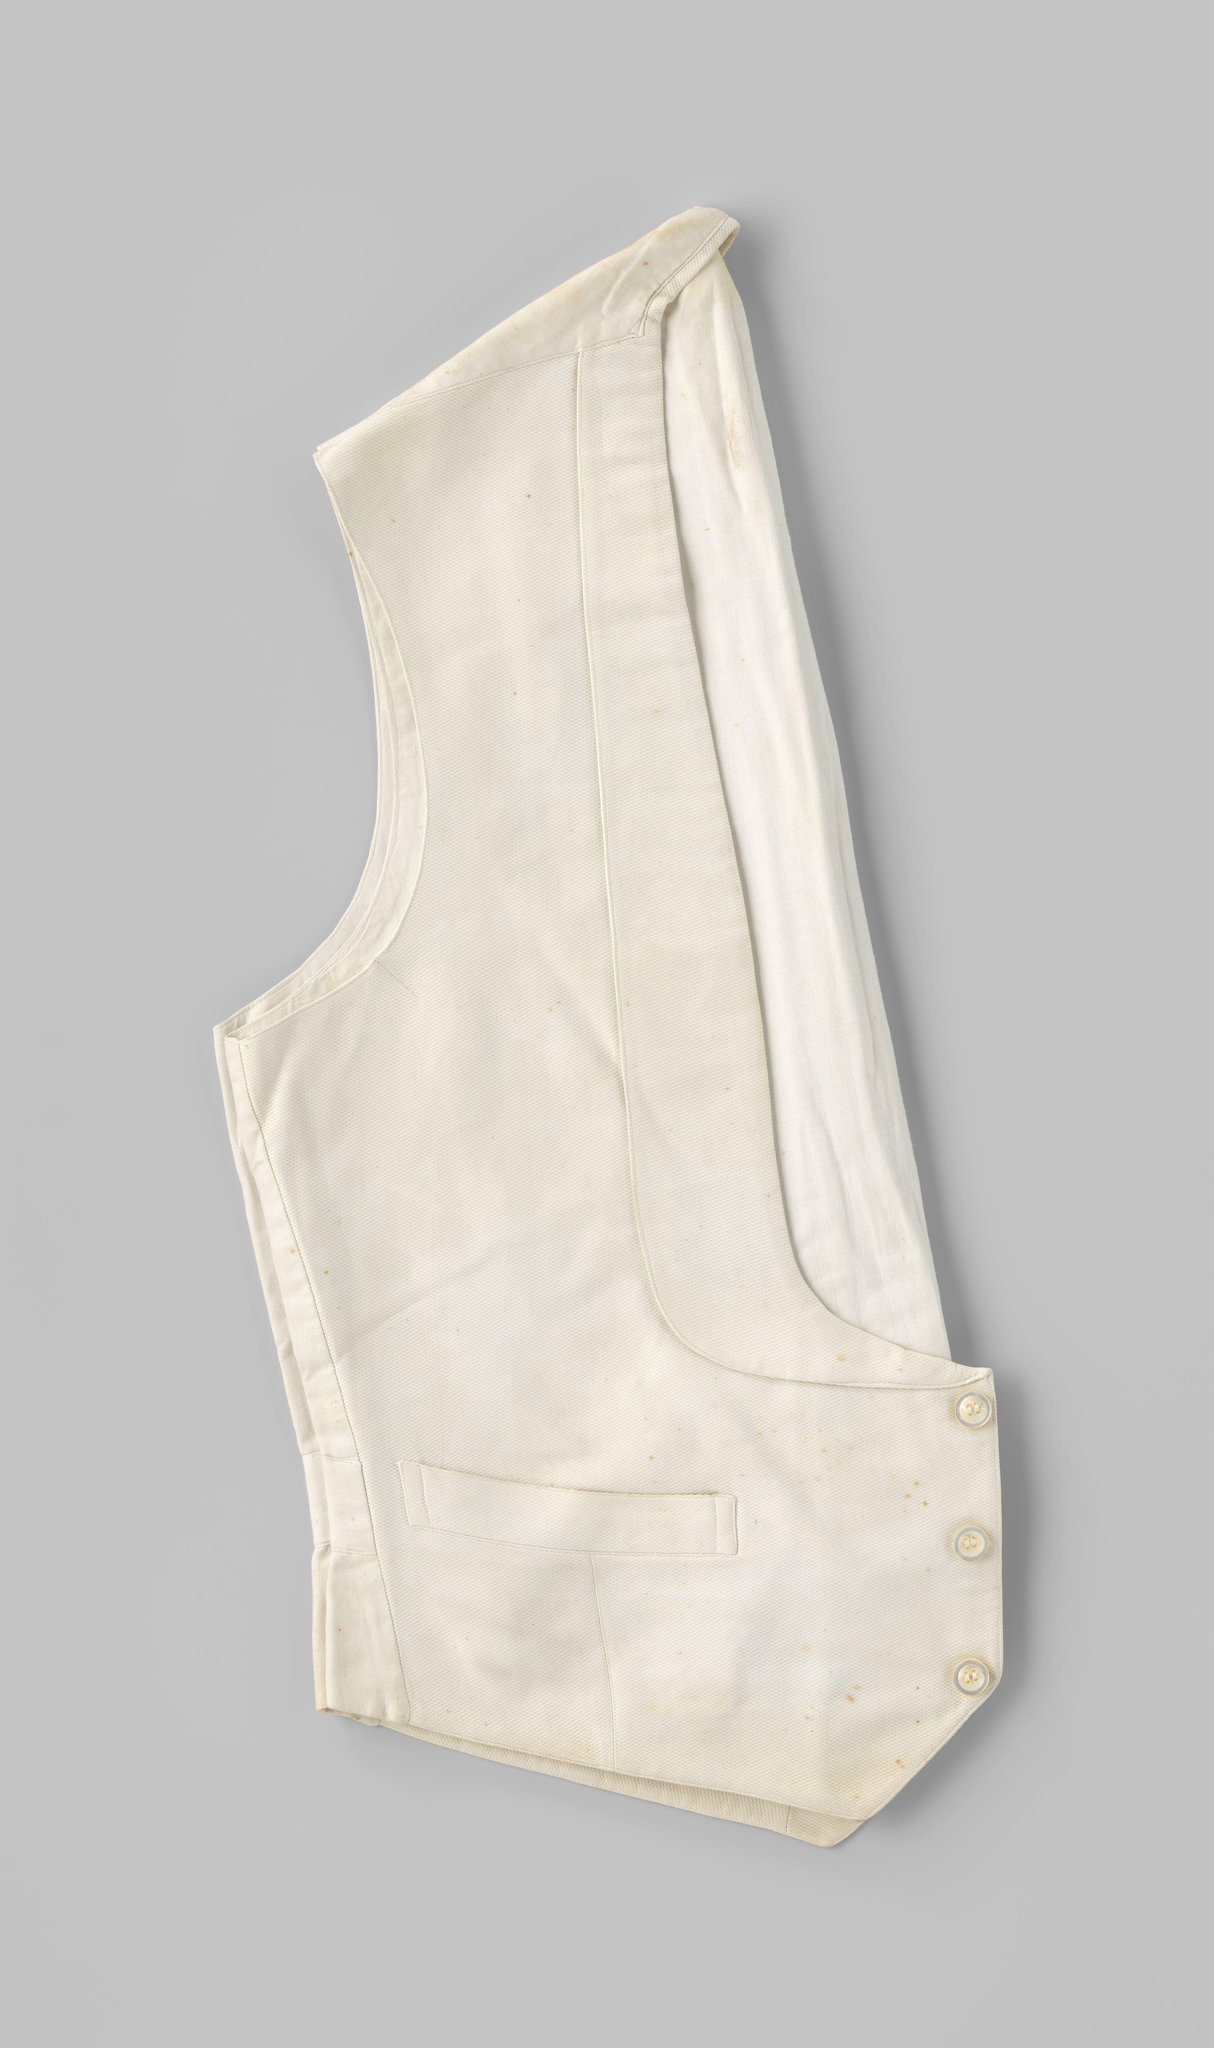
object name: menswear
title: Rokvest van wit piqué met wafelpatroon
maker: Anonymous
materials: textile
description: Rokvest van wit piqué met wafelpatroon. De panden onderaan met twee punten gesneden. Zeer lage, uitgeholde halsopening met ronde shawlkraag. Twee insteekzakken, waaronder coupenaadjes. Sluiting met drie parelmoeren knopen.